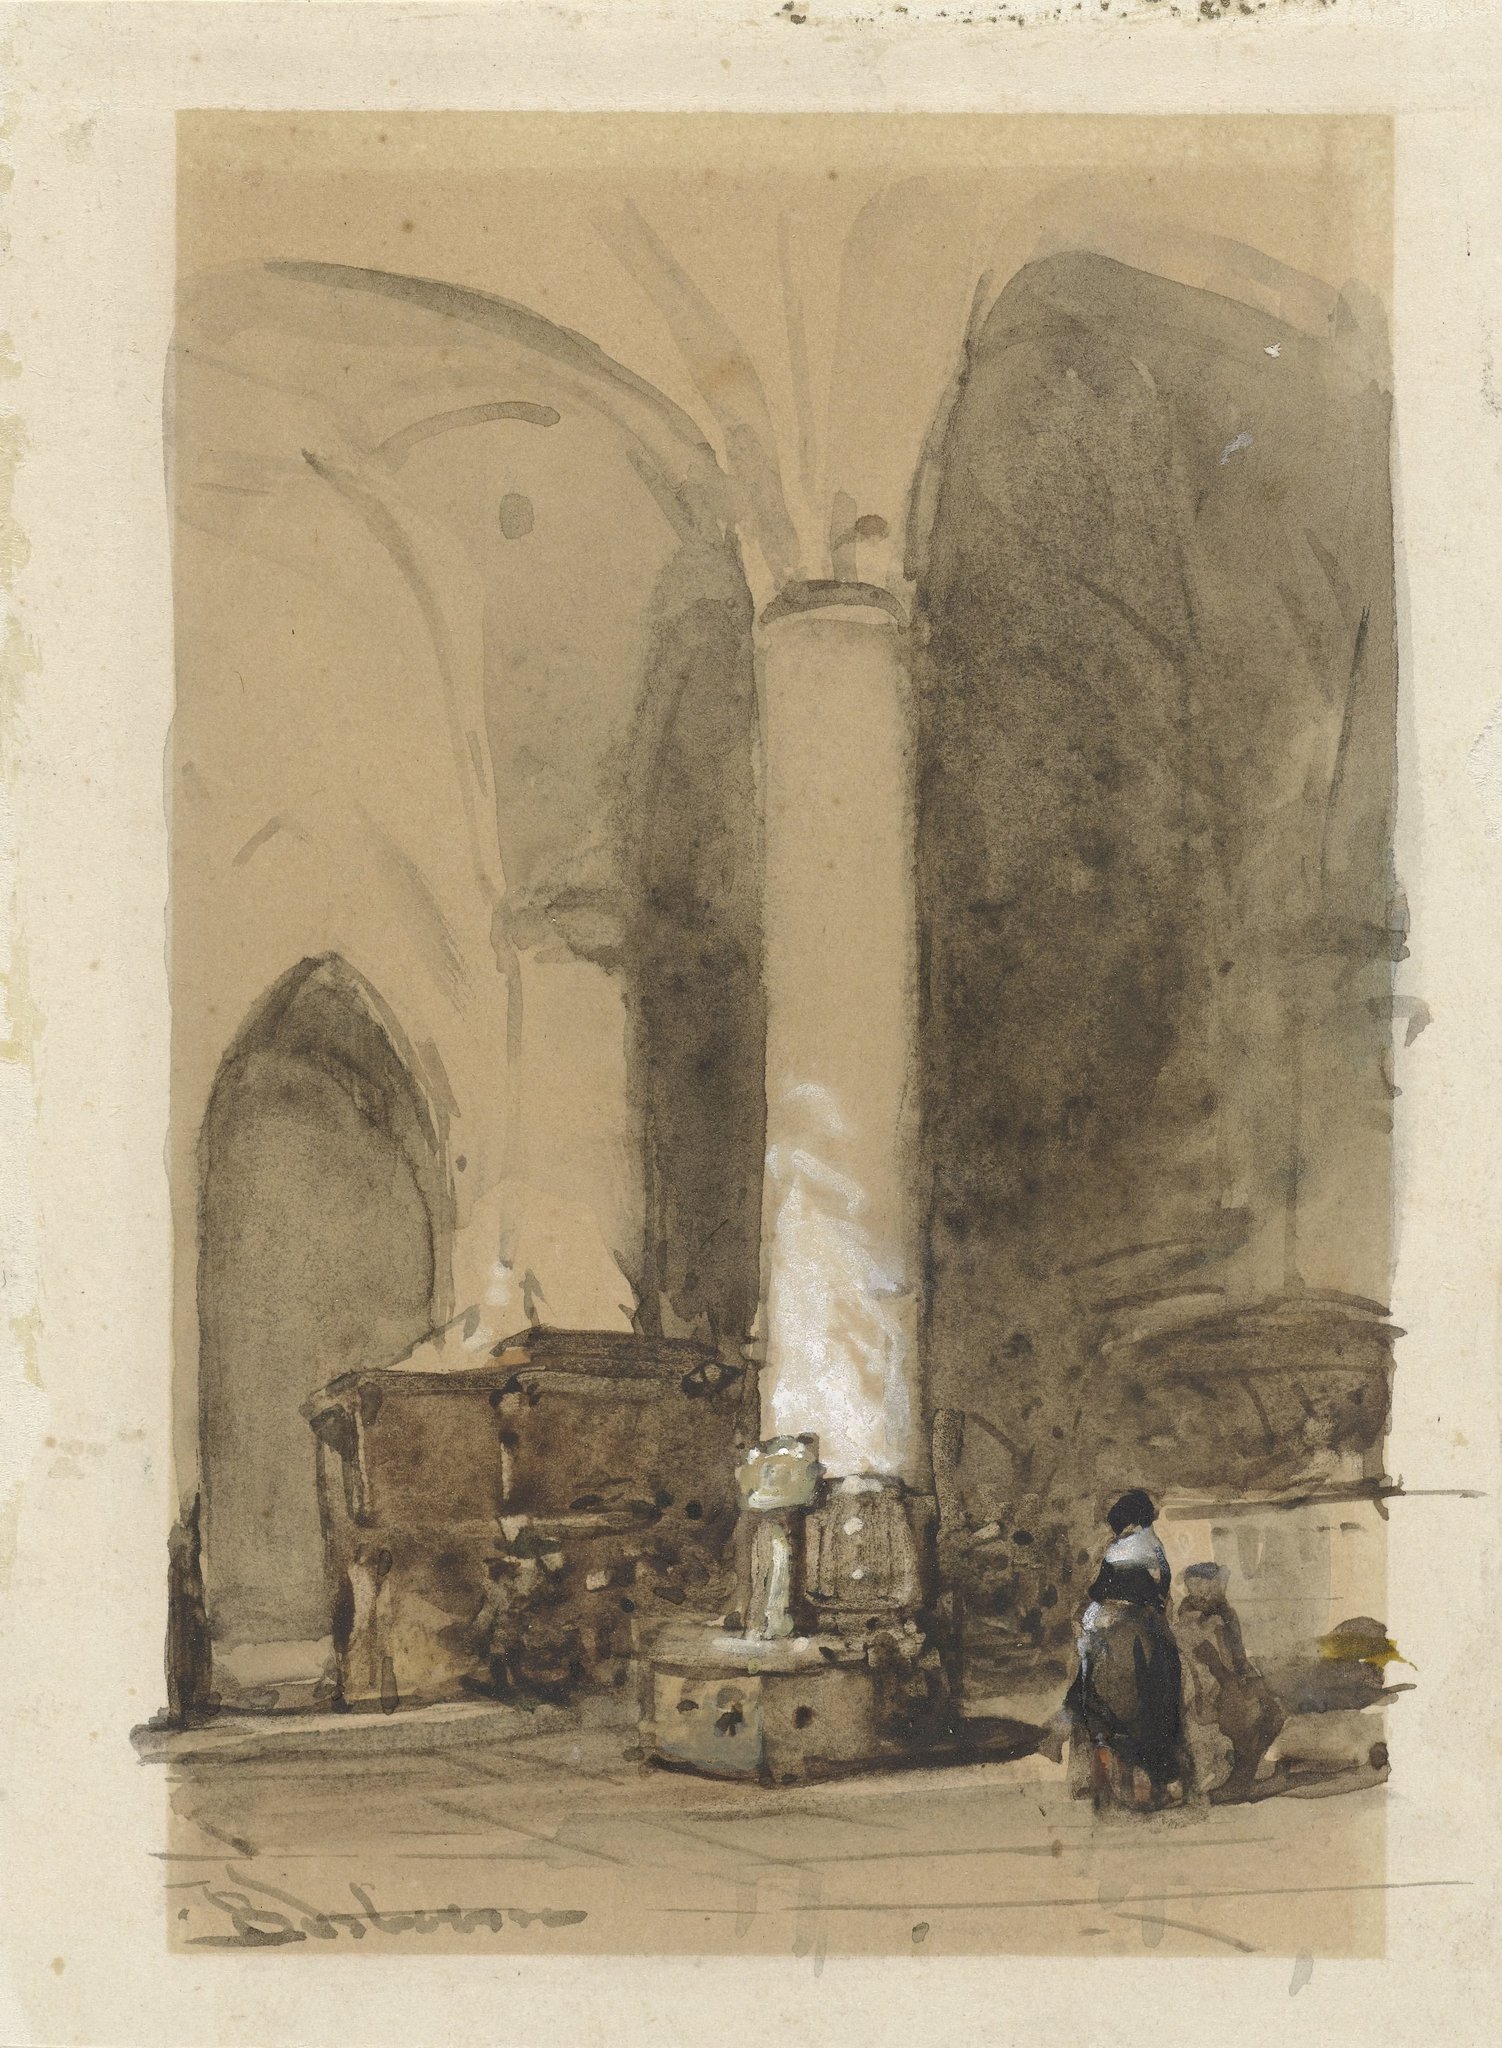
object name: drawing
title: Interieur van de Grote of Andreaskerk te Hattem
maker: johannes bosboom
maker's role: draughtsman, painter, print maker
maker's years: 1817-1891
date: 1851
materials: chalk, paint, paper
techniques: brush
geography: netherlands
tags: interior of church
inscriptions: signature: ‘JBosboom’